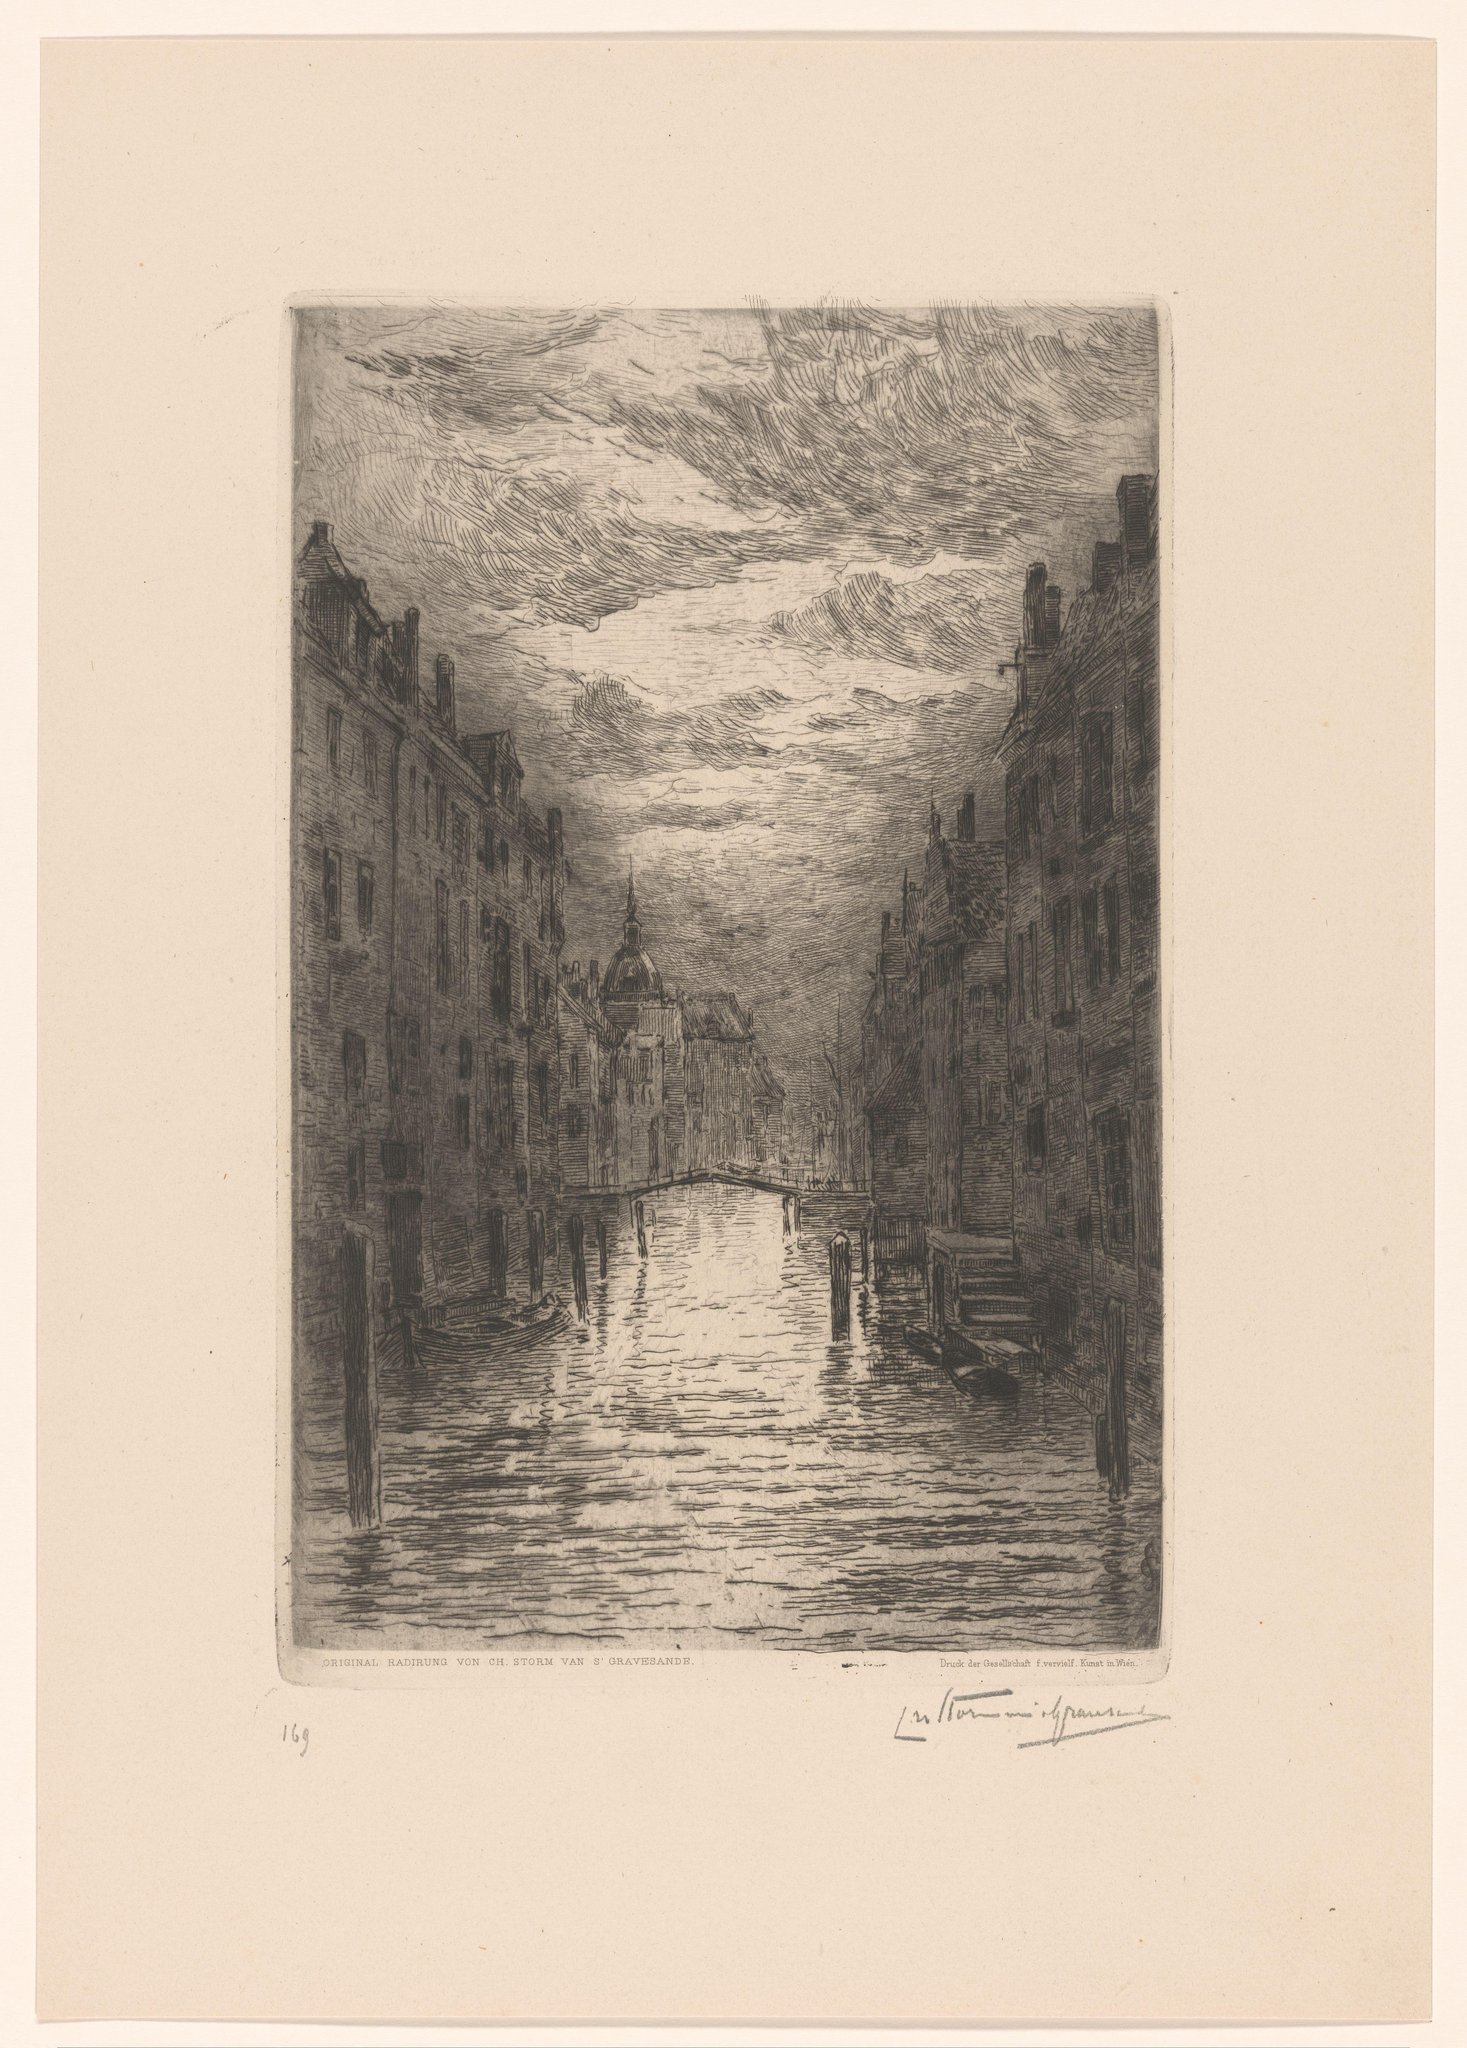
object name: print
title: Kanaal in Dordrecht bij avond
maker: carel nicolaas storm van s-gravesande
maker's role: draughtsman, print maker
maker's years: 1841-1924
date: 1851-1924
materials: paper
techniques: drypoint, etching, intaglio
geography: vienna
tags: canals, waters (in city)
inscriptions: collector's mark: Lugt 2228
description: Gezicht op een kanaal in Dordrecht. Links op de achtergrond de toren van de Groothoofdspoort.